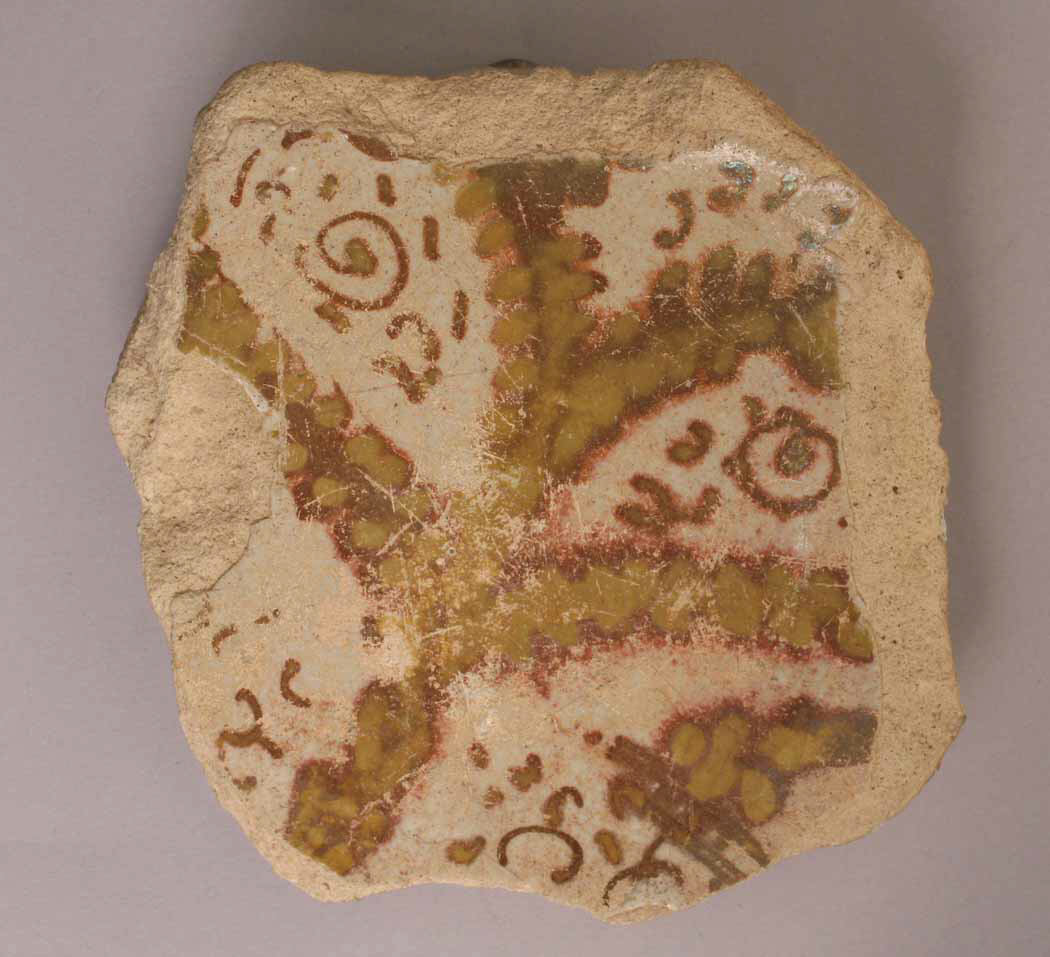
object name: ceramic fragment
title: Fragment of a Bowl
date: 901-1200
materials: earthenware, glaze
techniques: luster painting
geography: egypt